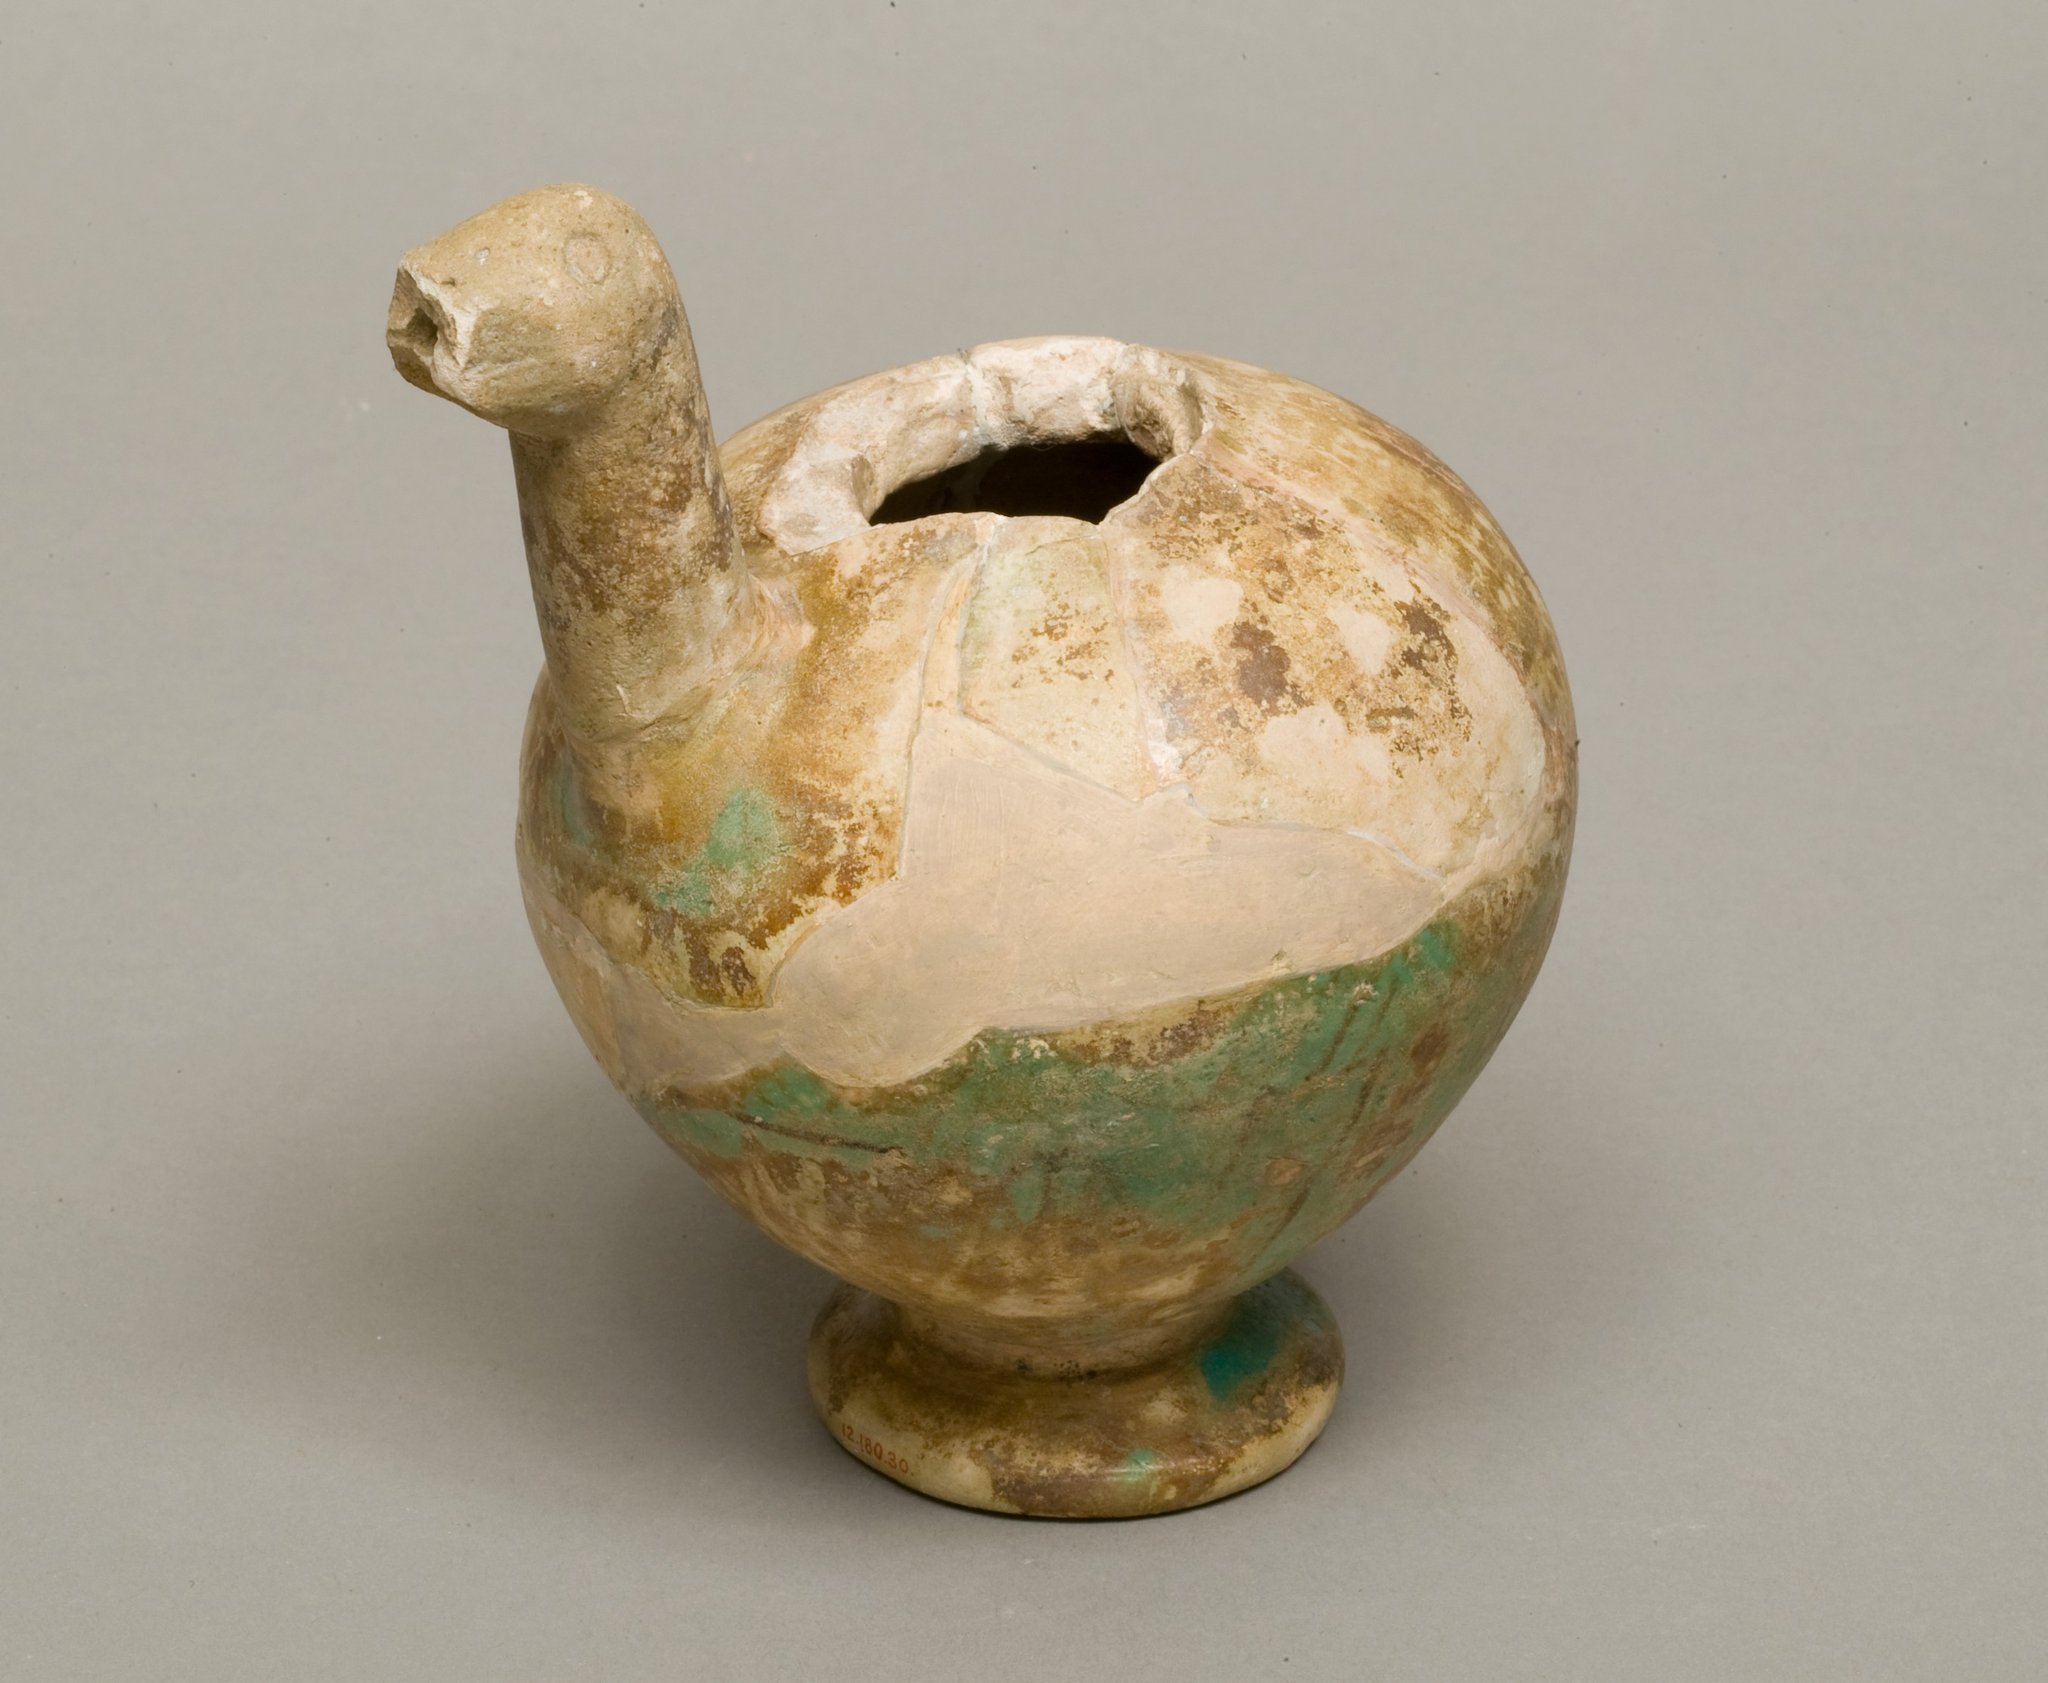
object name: vase, bird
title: Bird shaped vase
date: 1981-1640 BCE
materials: faience, paint, paste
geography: egypt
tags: birds